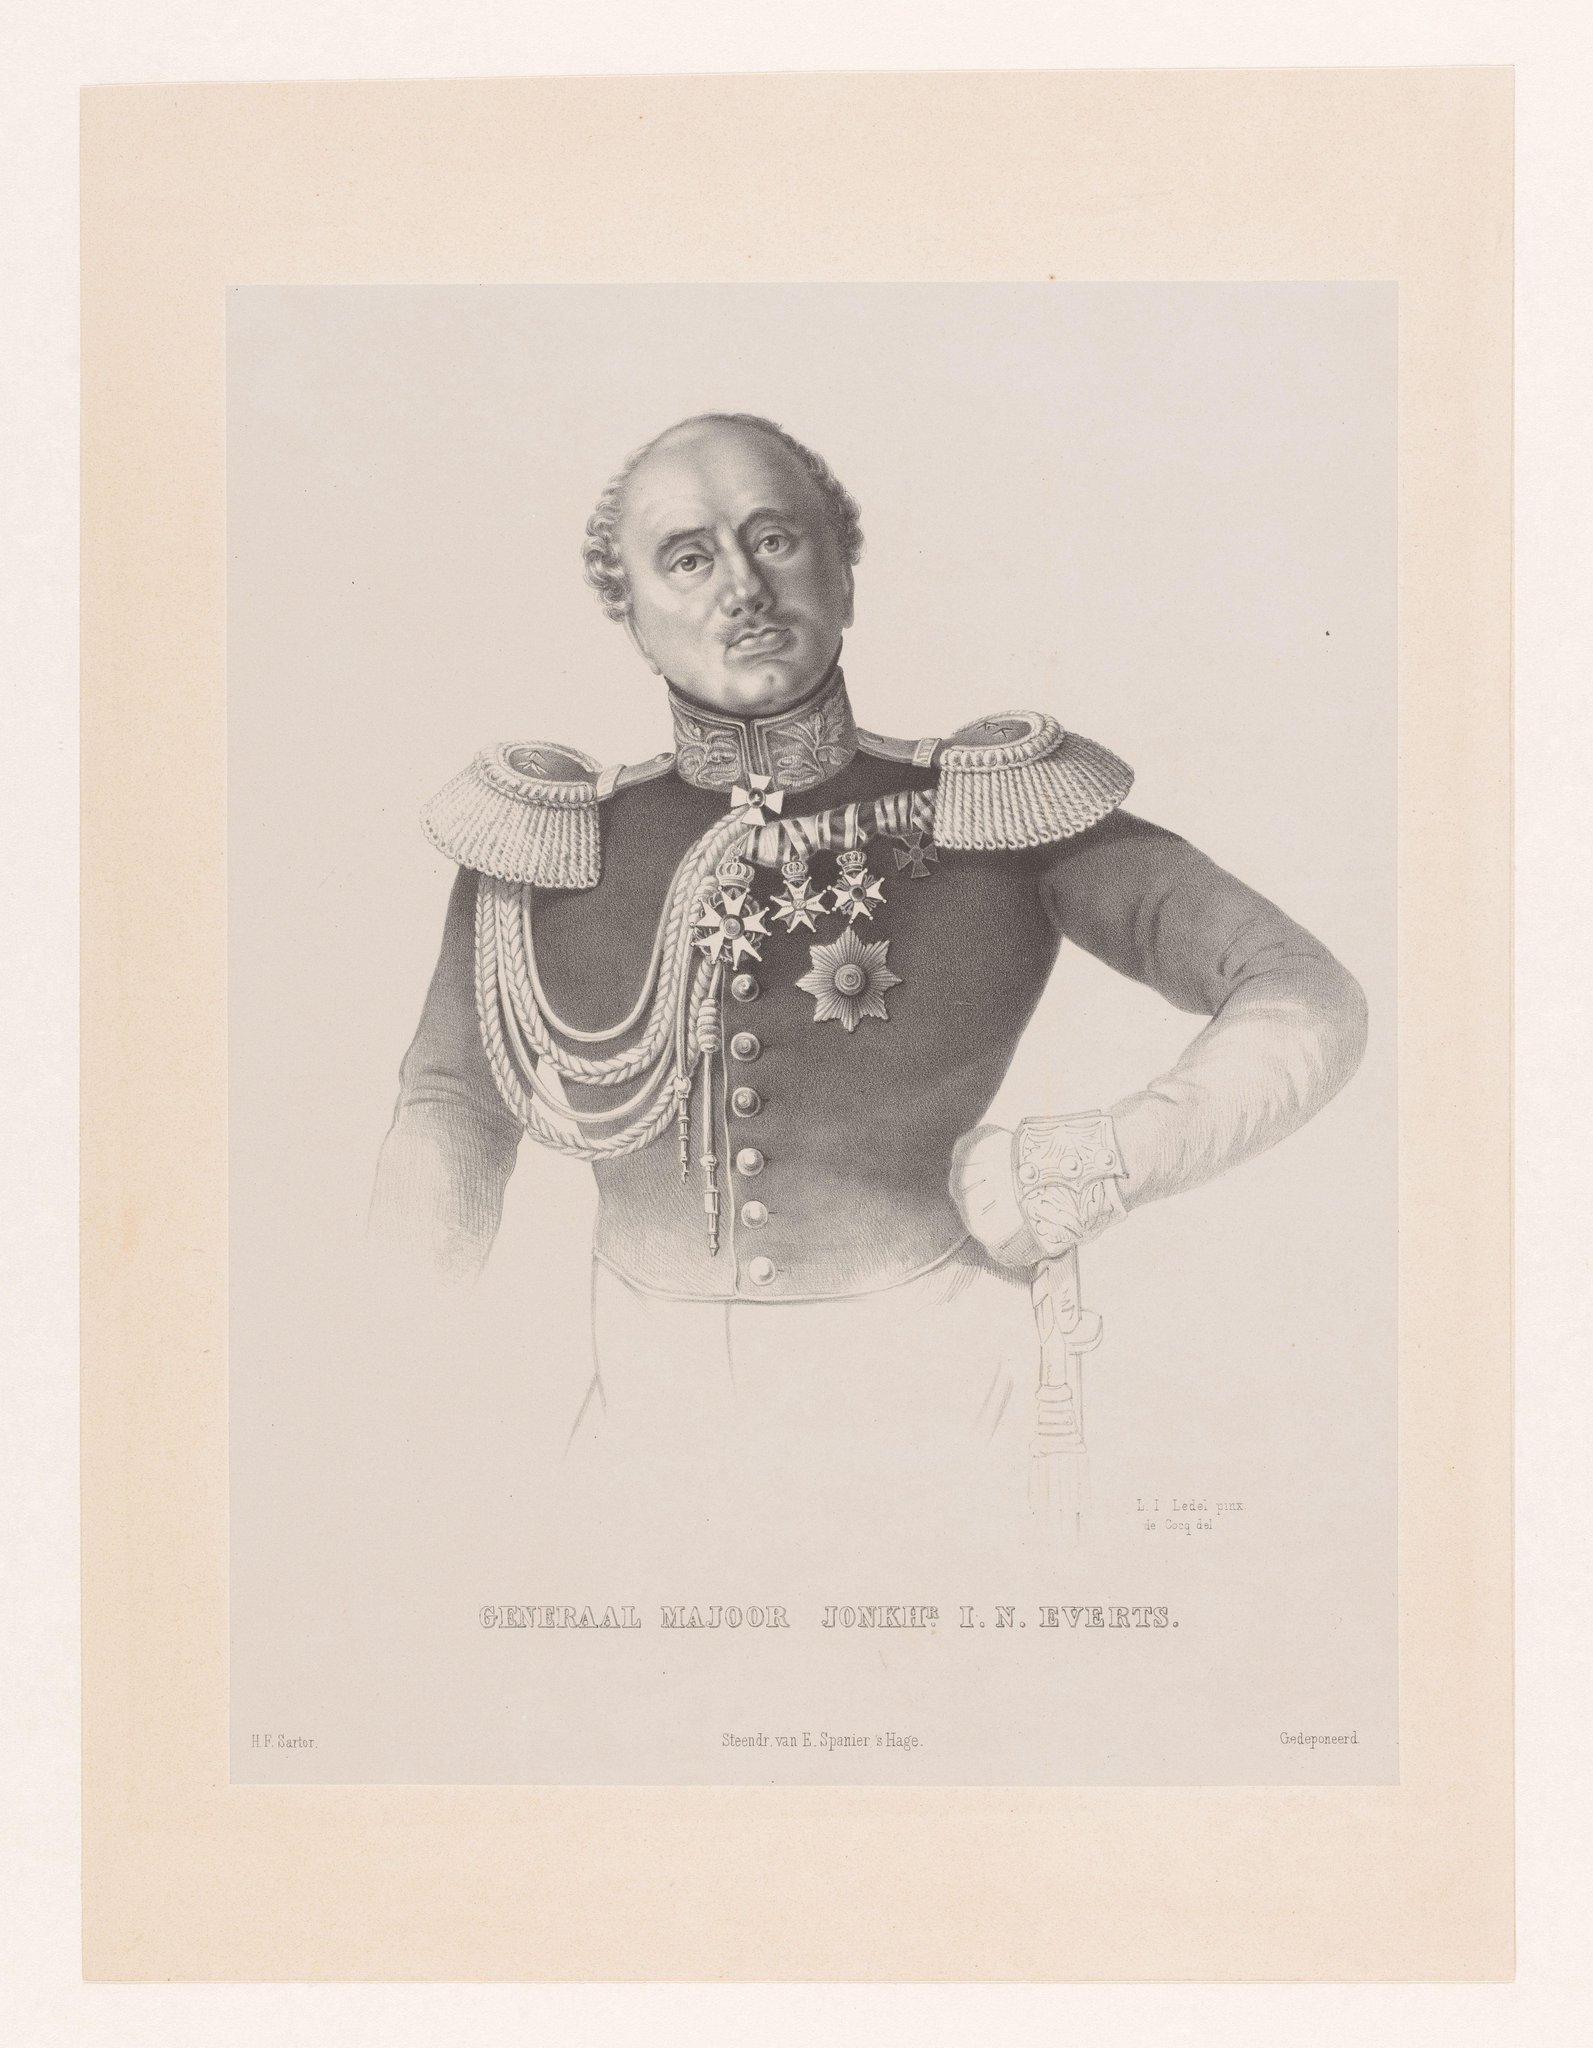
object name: print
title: Generaal majoor jonkhr I.N. Everts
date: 1831-1853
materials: paper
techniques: lithograph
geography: the hague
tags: the hague, historical persons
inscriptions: collector's mark: Lugt 2228, : ‘Gedeponeerd’